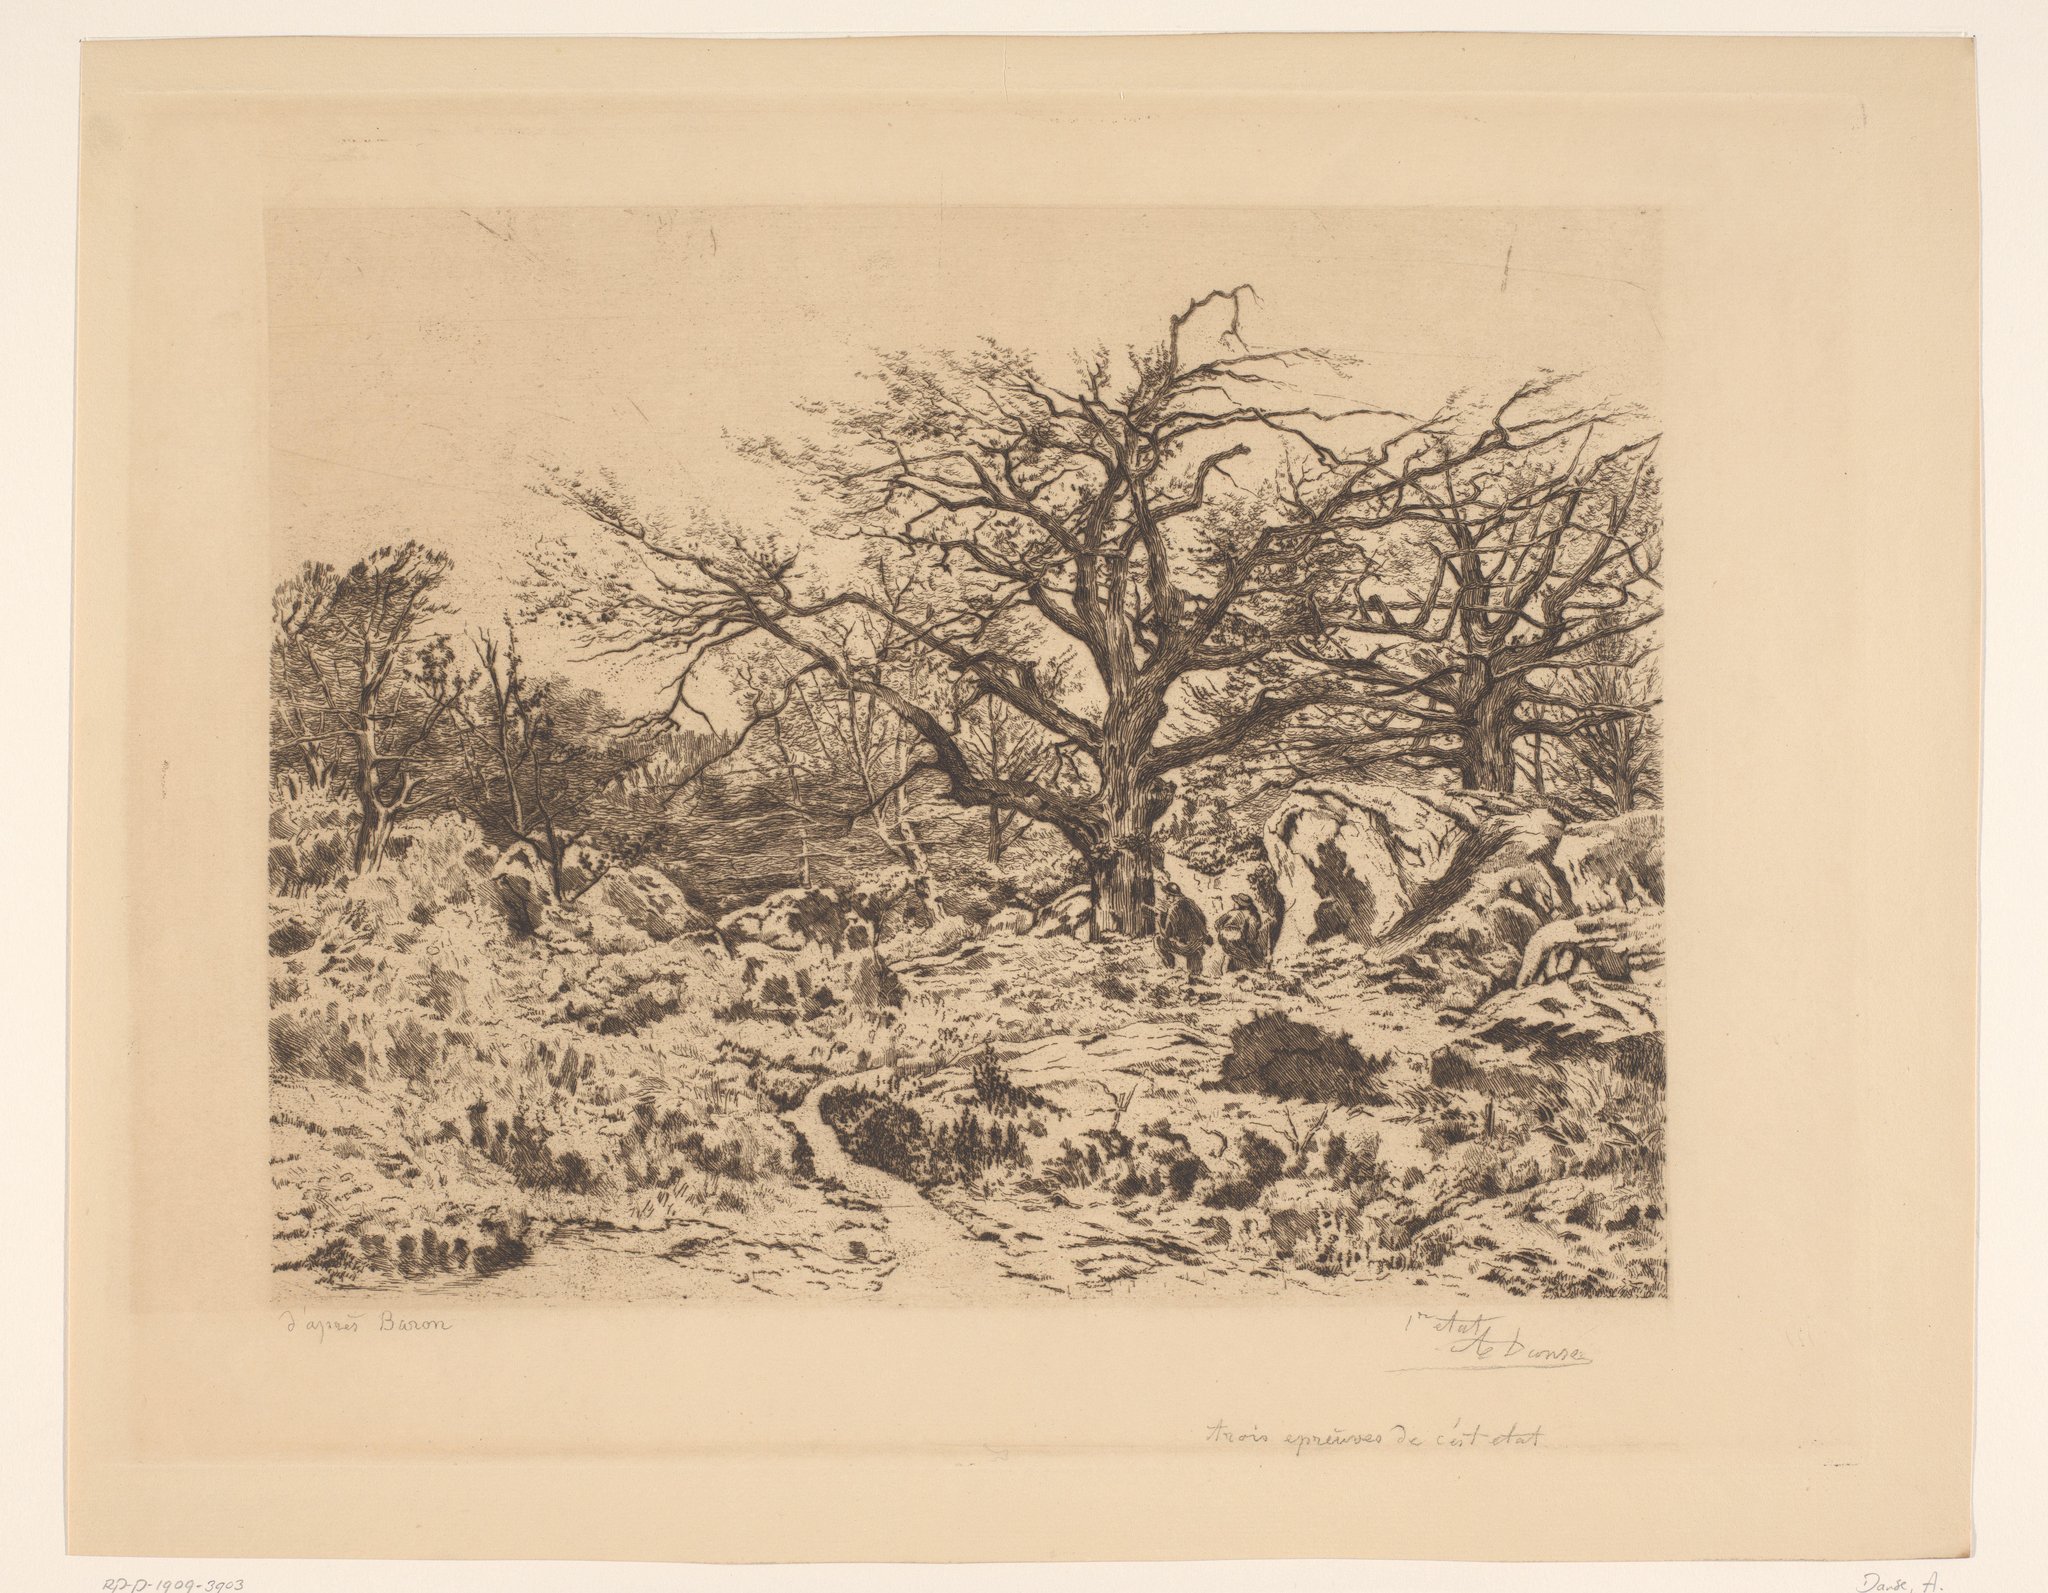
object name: print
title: Jagers in het bos van Fontainebleau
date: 1897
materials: paper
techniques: drypoint, etching, intaglio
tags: hunters hunting (n.b.: in 1988-1990 this notation denoted the concept of 43c11421 'hunters resting during the hunt')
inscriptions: annotation: ‘1er etat; trois epreuves de c'est etat’, collector's mark: Lugt 2228